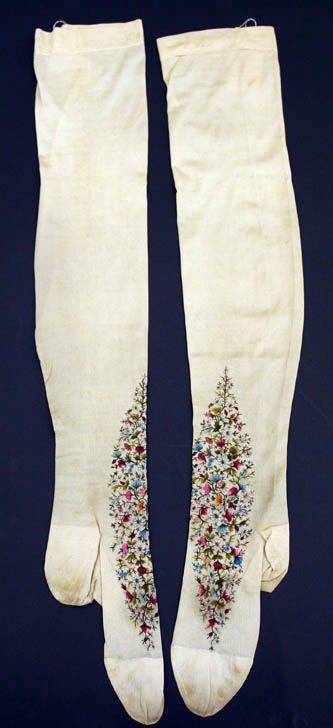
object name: stocking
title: Stockings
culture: french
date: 1880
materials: silk